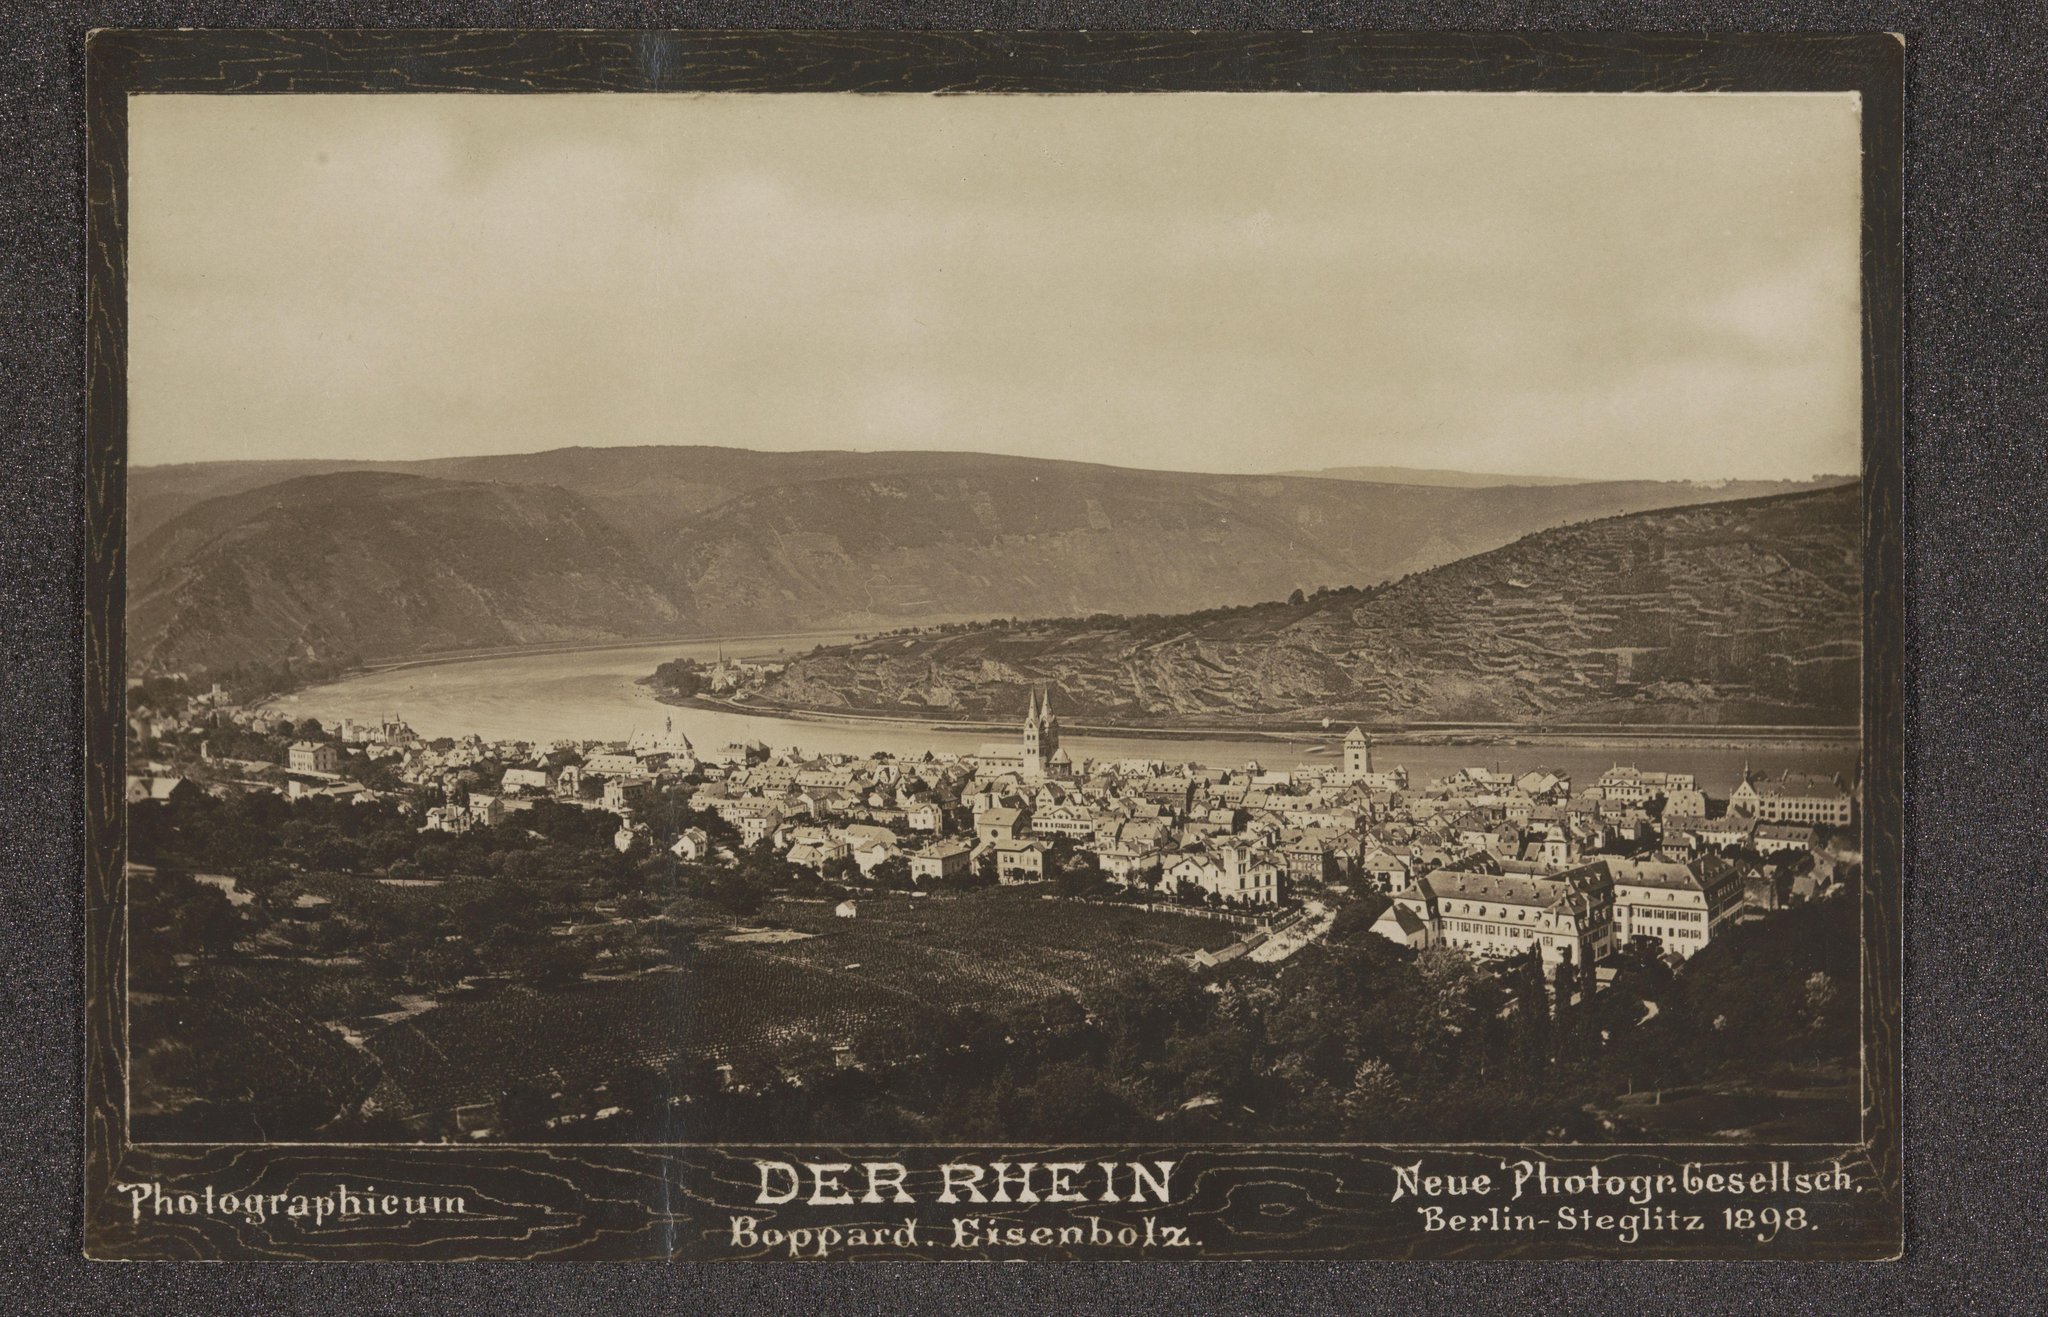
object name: photograph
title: Der Rhein Boppard. Eisenholz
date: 1870-1898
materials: photographic support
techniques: gelatin silver print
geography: boppard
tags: travelling; tourism, river (+ landscape with figures, staffage), prospect of city, town panorama, silhouette of city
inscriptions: inscription: ‘Berlin-Steglitz 1898’, inscription: ‘Photographicum’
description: Foto hoort bij een serie van 28 losse prentbriefkaarten van Engeland, Noorwegen, Italië, Duitsland en Tirol (foto's RP-F-F00945-1 t/m RP-F-F00945-28).